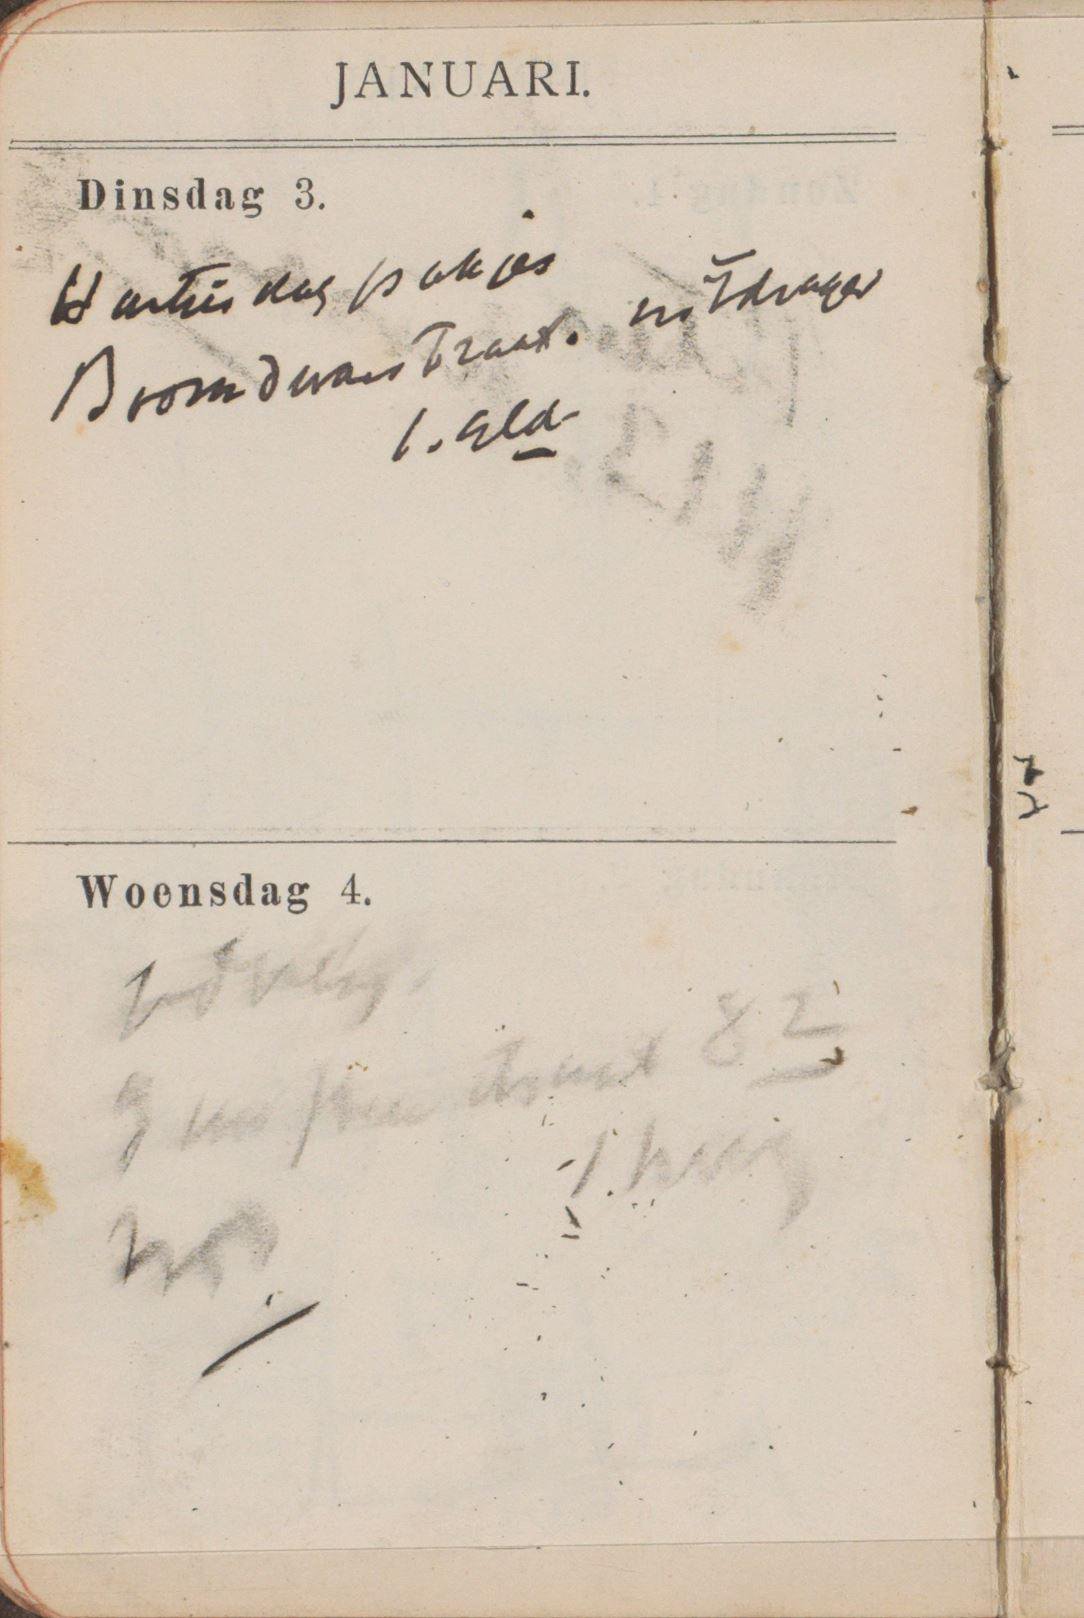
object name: sketchbook leaf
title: Annotaties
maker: george hendrik breitner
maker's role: draughtsman, painter, print maker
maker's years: 1857-1923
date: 1893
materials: ink, paper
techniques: writing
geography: amsterdam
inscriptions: annotation: ‘Hartjesdag pakjes/ Boomdwarsstraat. uitdrager/ 1. gld.’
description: Pagina 23 uit een als schetsboek gebruikte agenda met 108 bladen.